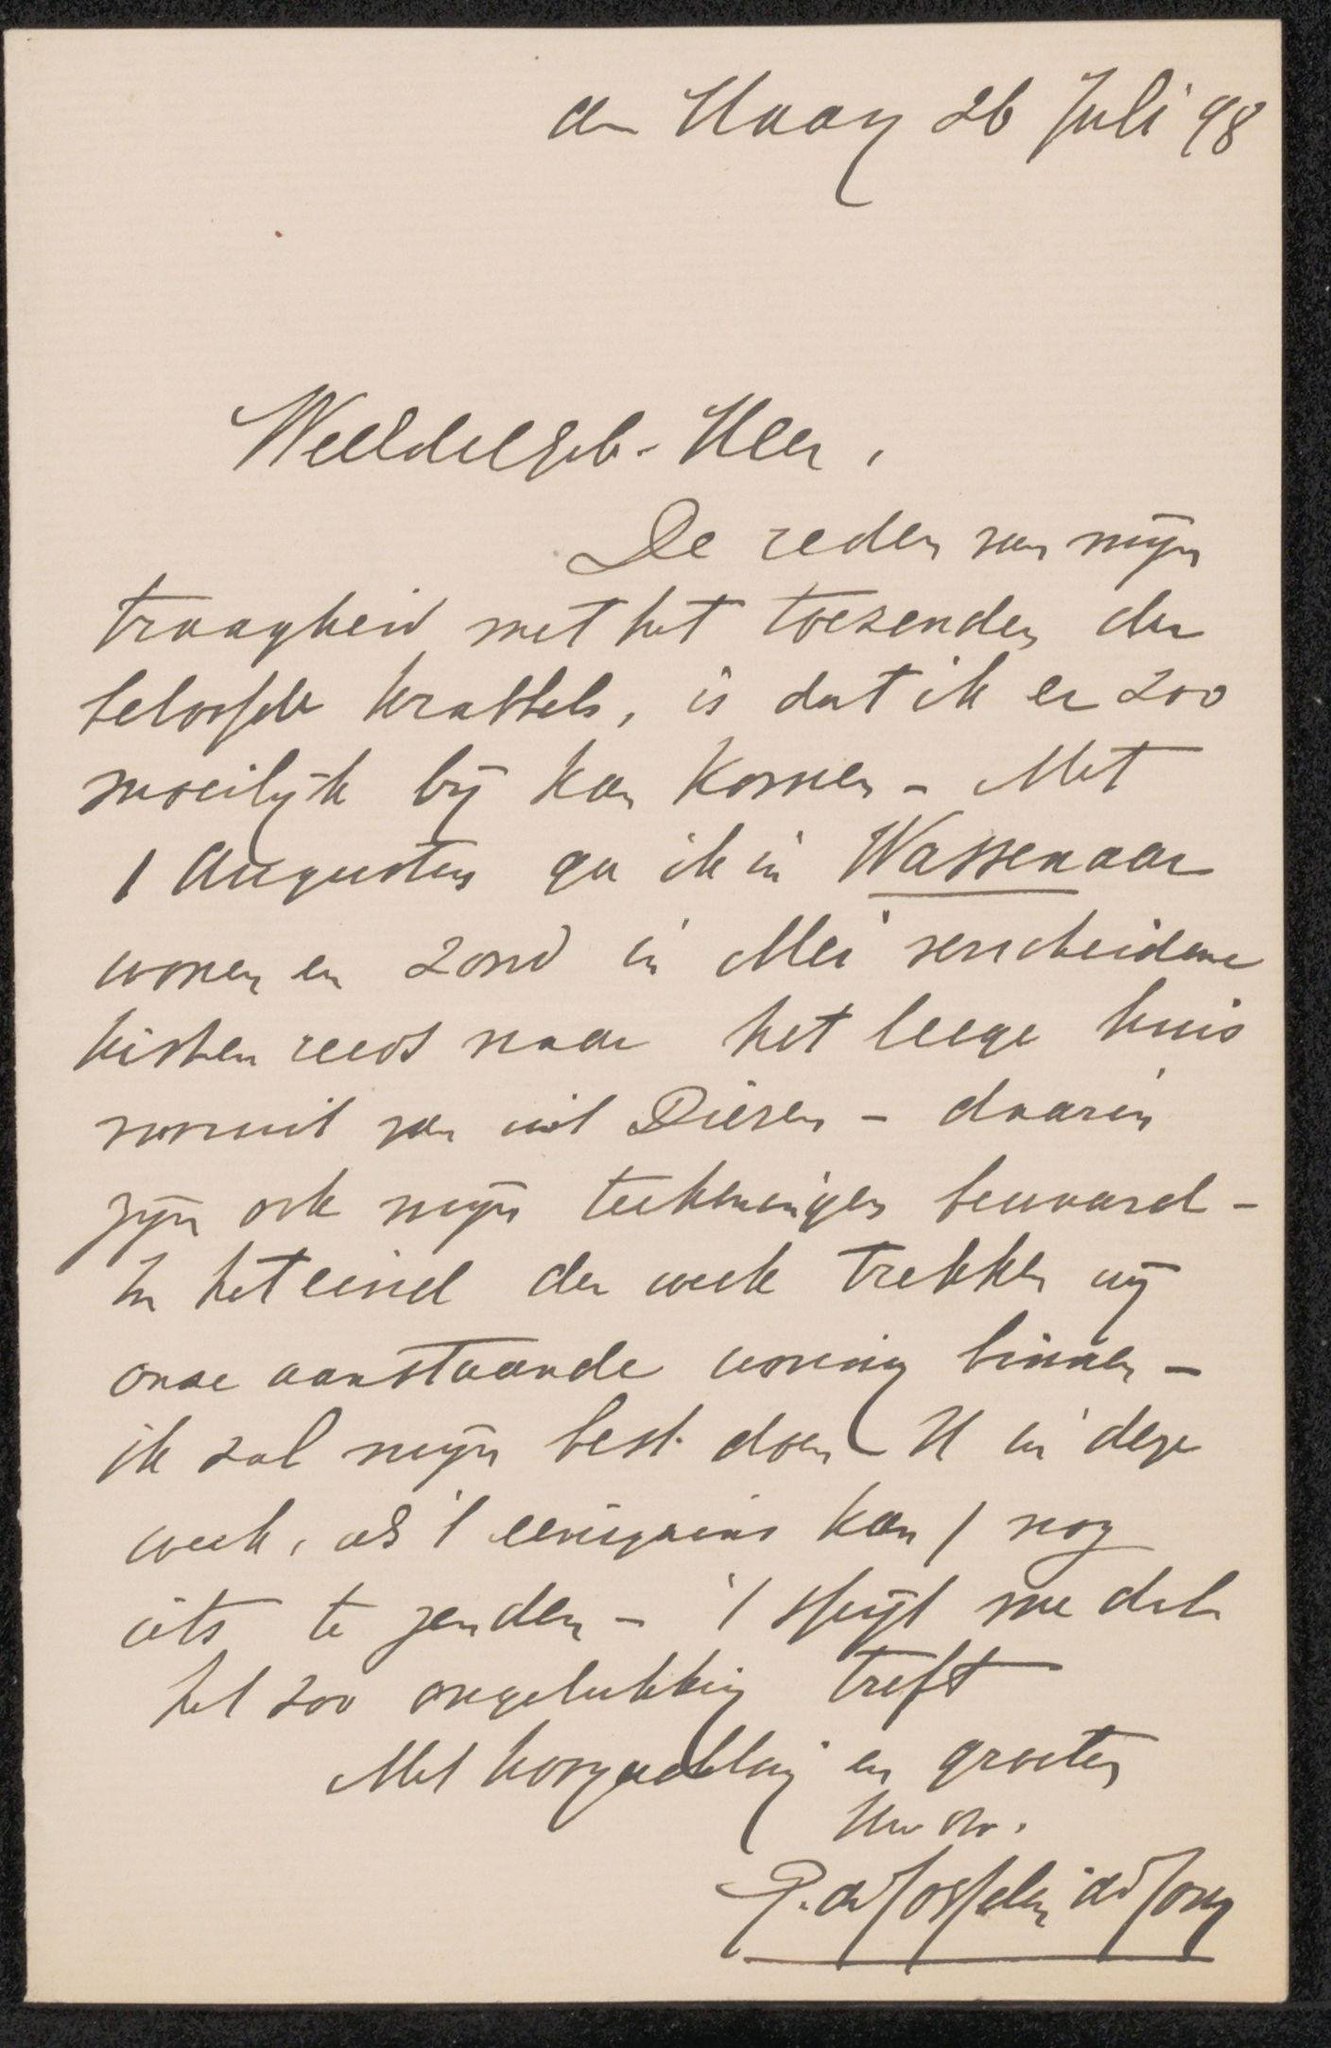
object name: letter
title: Brief aan Pieter Haverkorn van Rijsewijk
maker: pieter de josselin de jong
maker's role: draughtsman, painter, print maker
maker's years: 1861-1906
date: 1898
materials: ink, paper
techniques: pen, writing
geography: the hague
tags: pieter haverkorn van rijsewijk, drawing